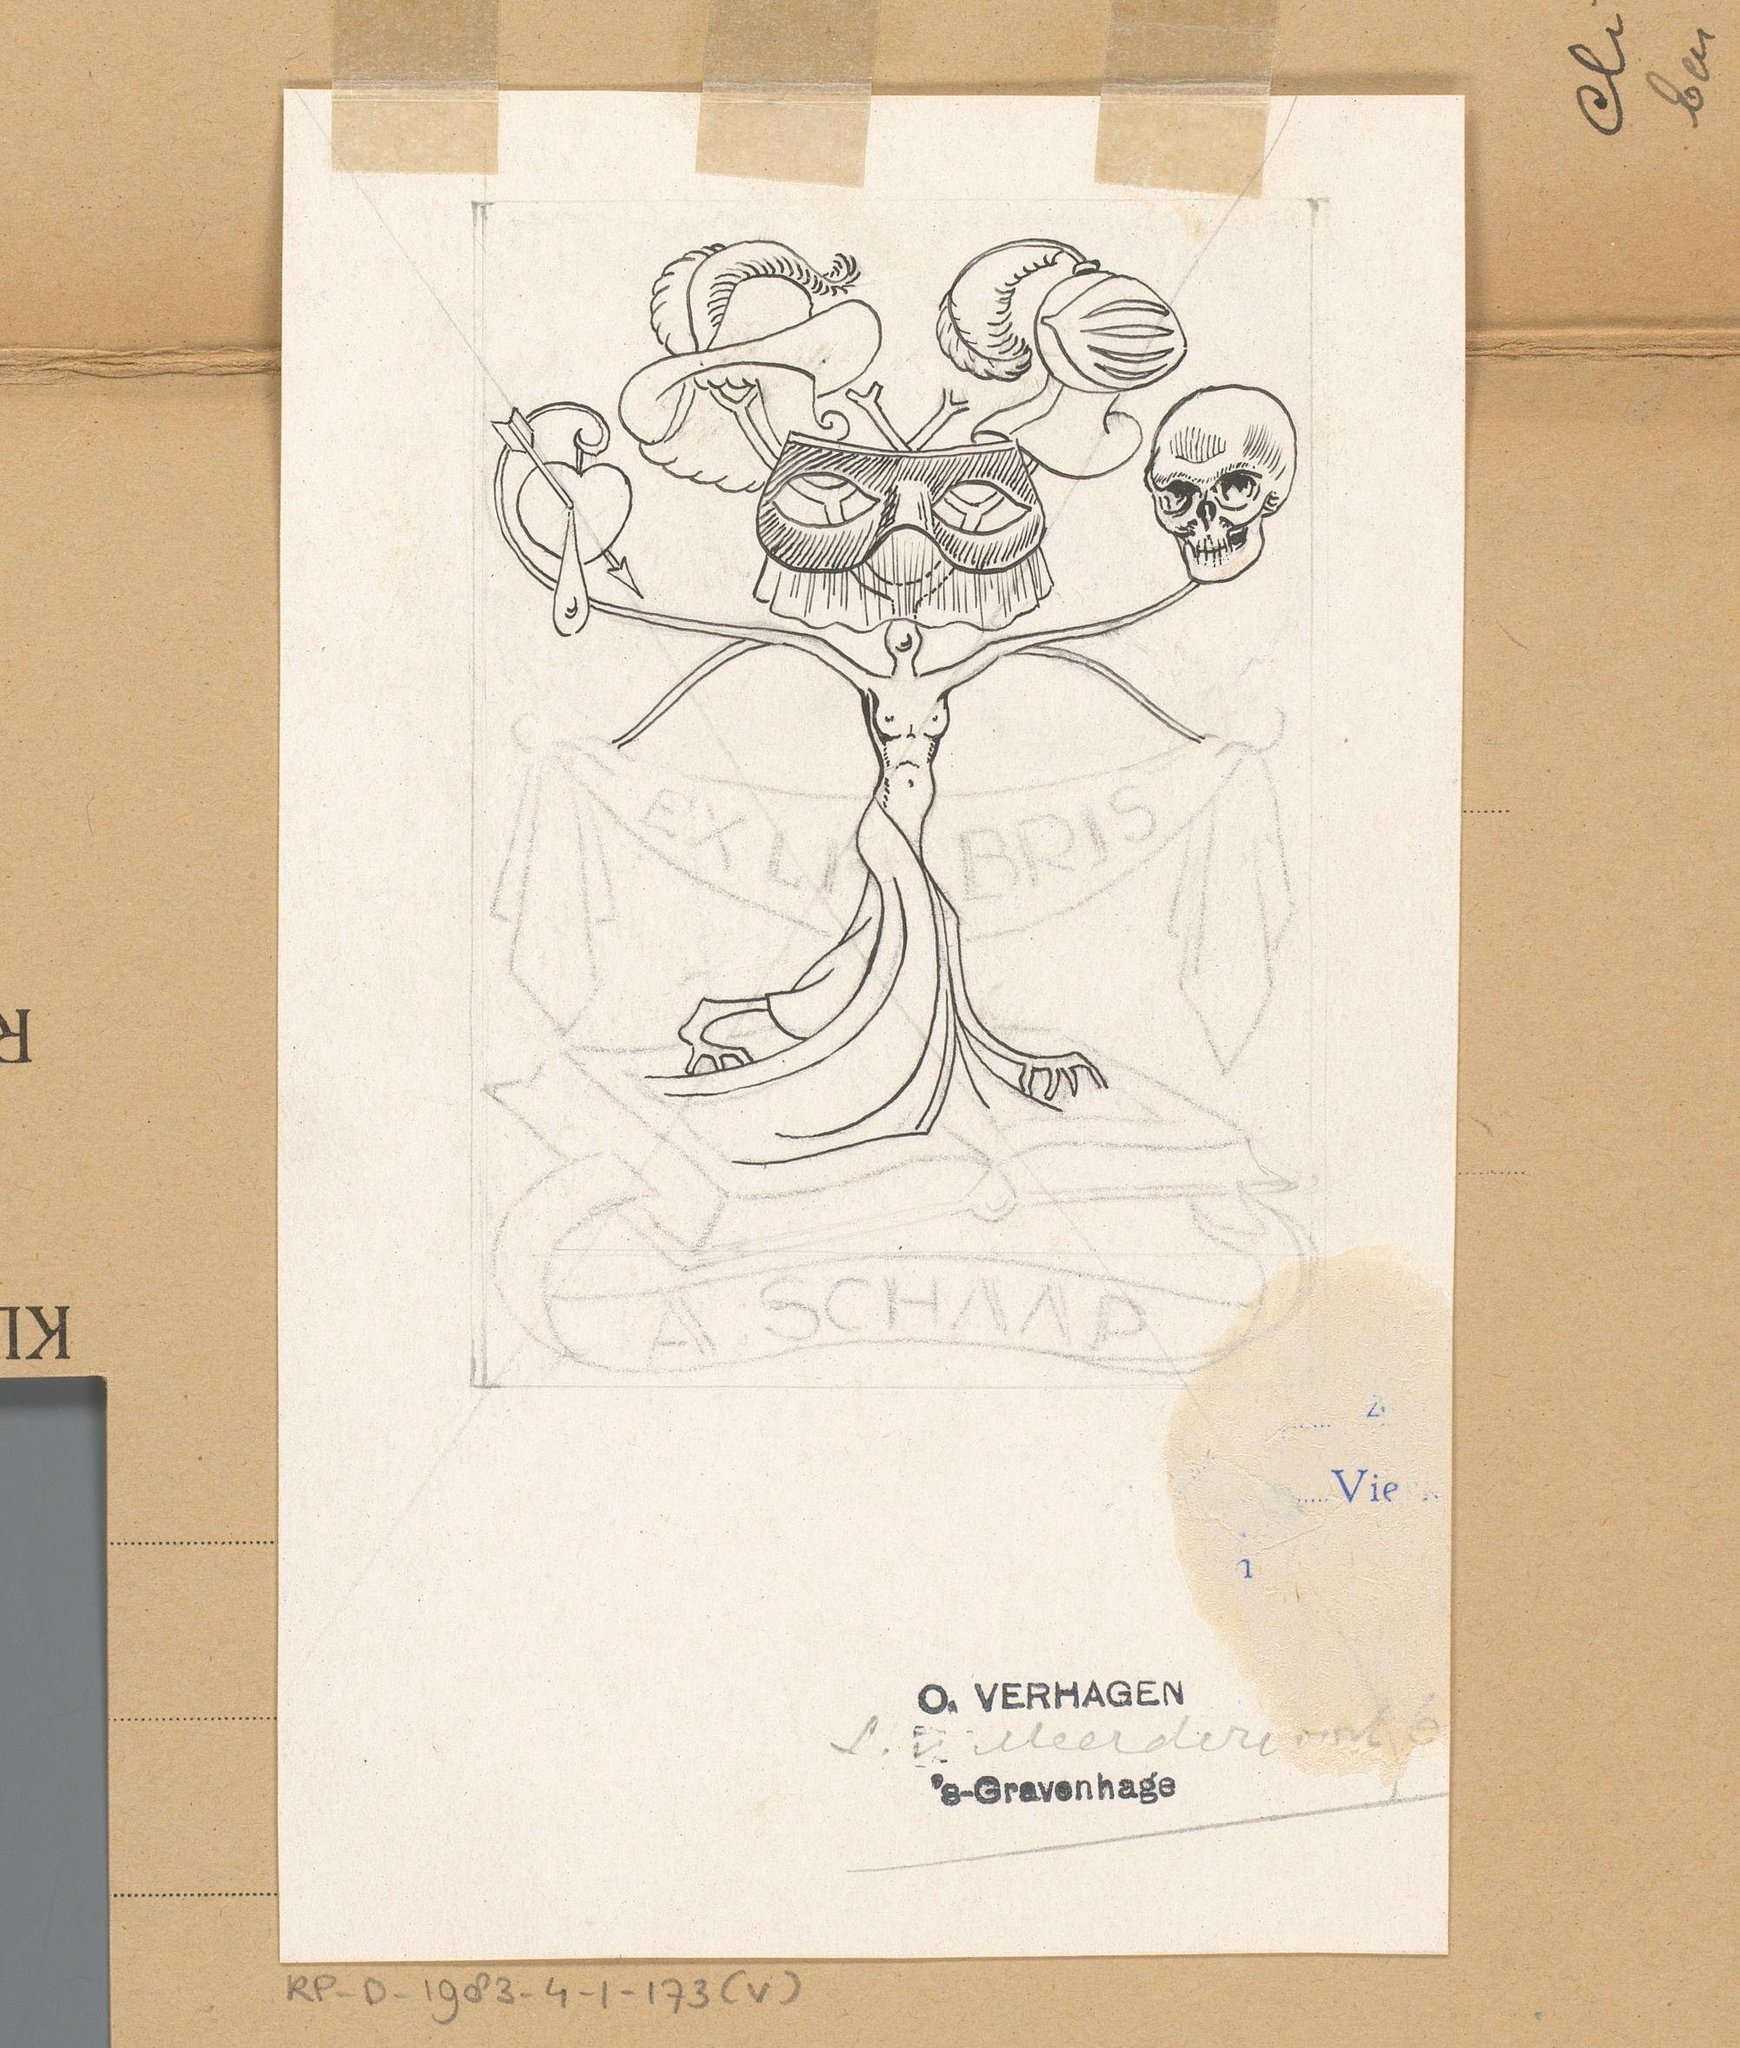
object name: design drawing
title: Ex libris A. Schaap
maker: otto verhagen (i)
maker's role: draughtsman, print maker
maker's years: 1885-1951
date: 1950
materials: ink, paper, pencil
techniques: drawing, pen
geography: netherlands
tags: mask, trees, (human) skull, book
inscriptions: workshop stamp: ‘O. Verhagen/ 's-Gravenhage’